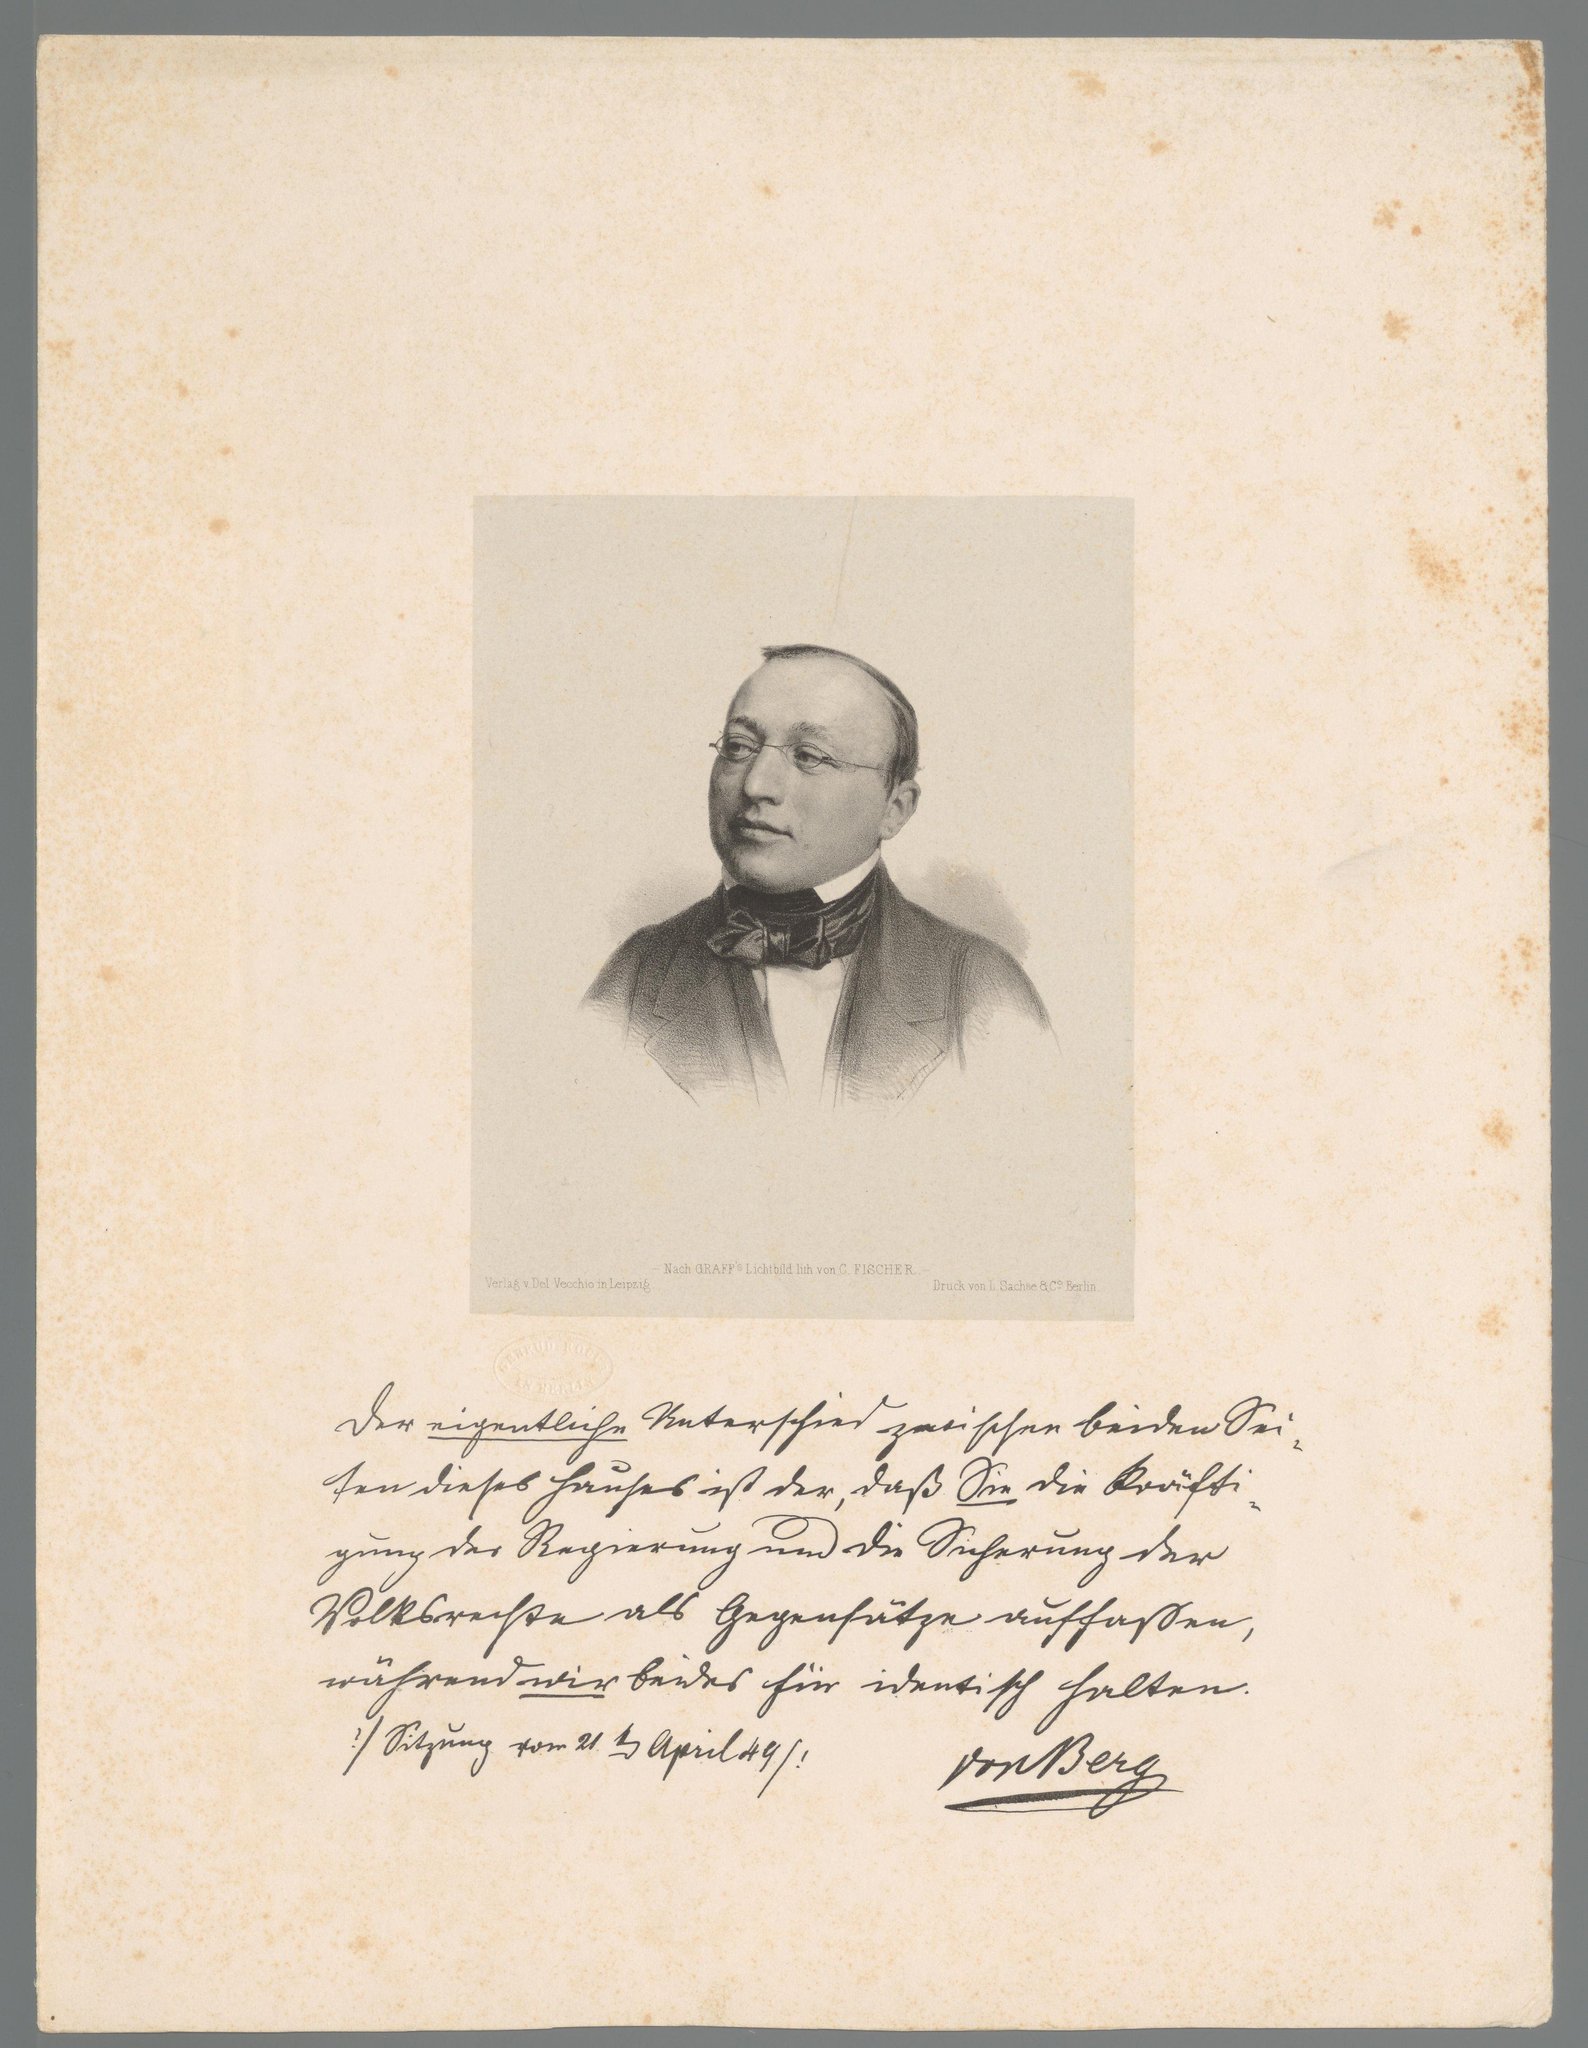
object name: print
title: Portret van een onbekende man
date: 1849-1854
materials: paper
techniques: lithograph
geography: leipzig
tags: historical persons not known by name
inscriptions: check stamp: Lugt 2141c, collector's mark: Lugt 2228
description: Prent naar een foto door Philipp Graff, uit een reeks portretten van afgevaardigden van de Frankfurter Nationalversammlung.